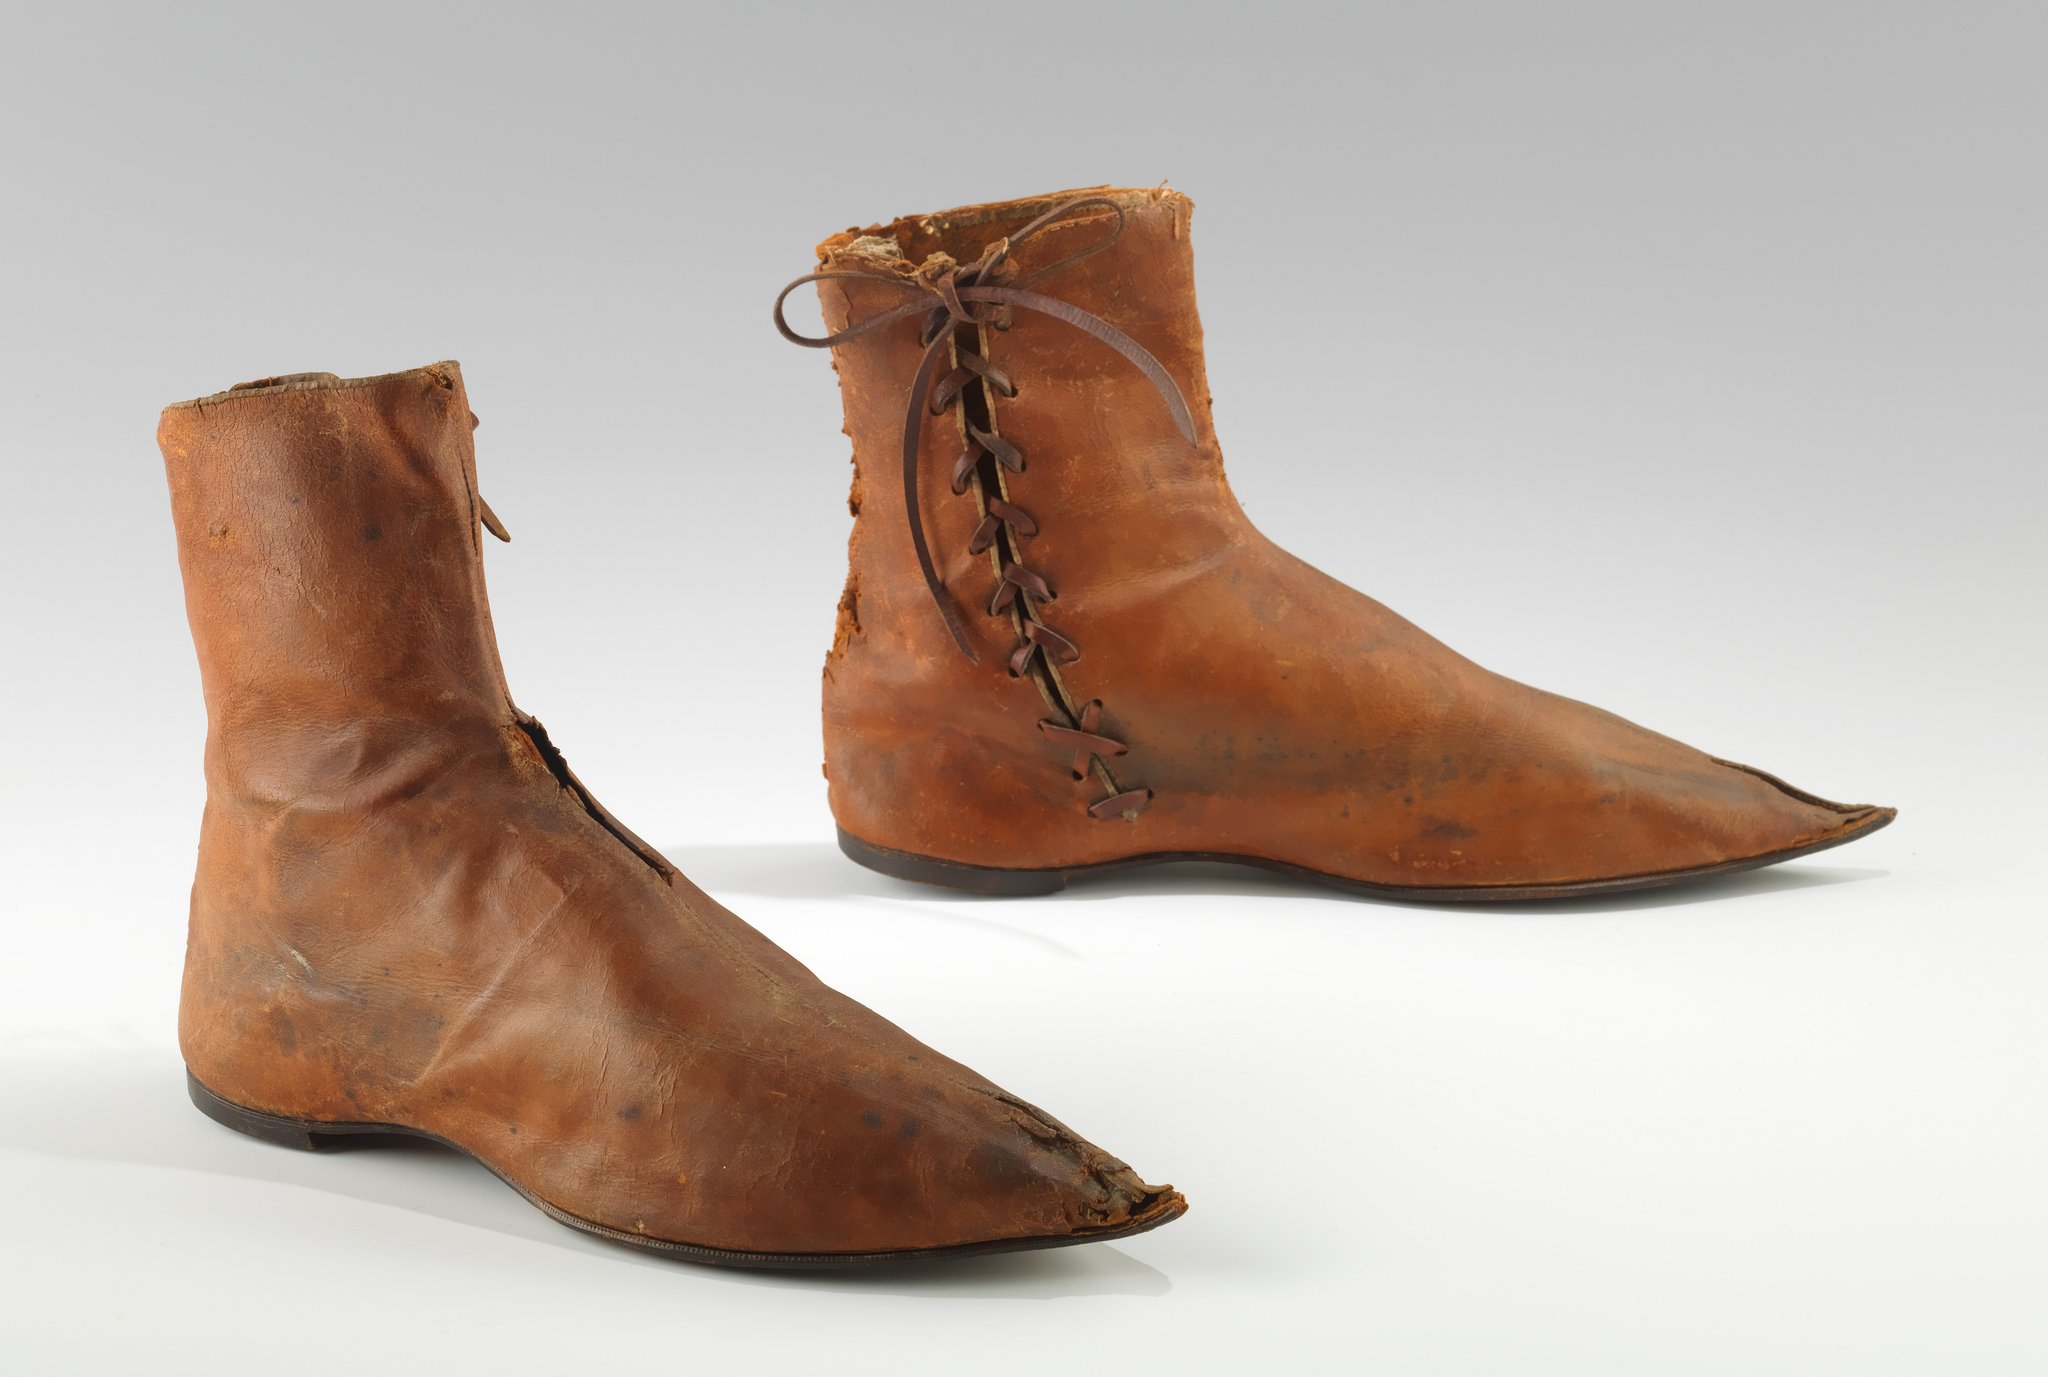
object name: boot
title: Boots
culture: british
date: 1790-1820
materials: leather